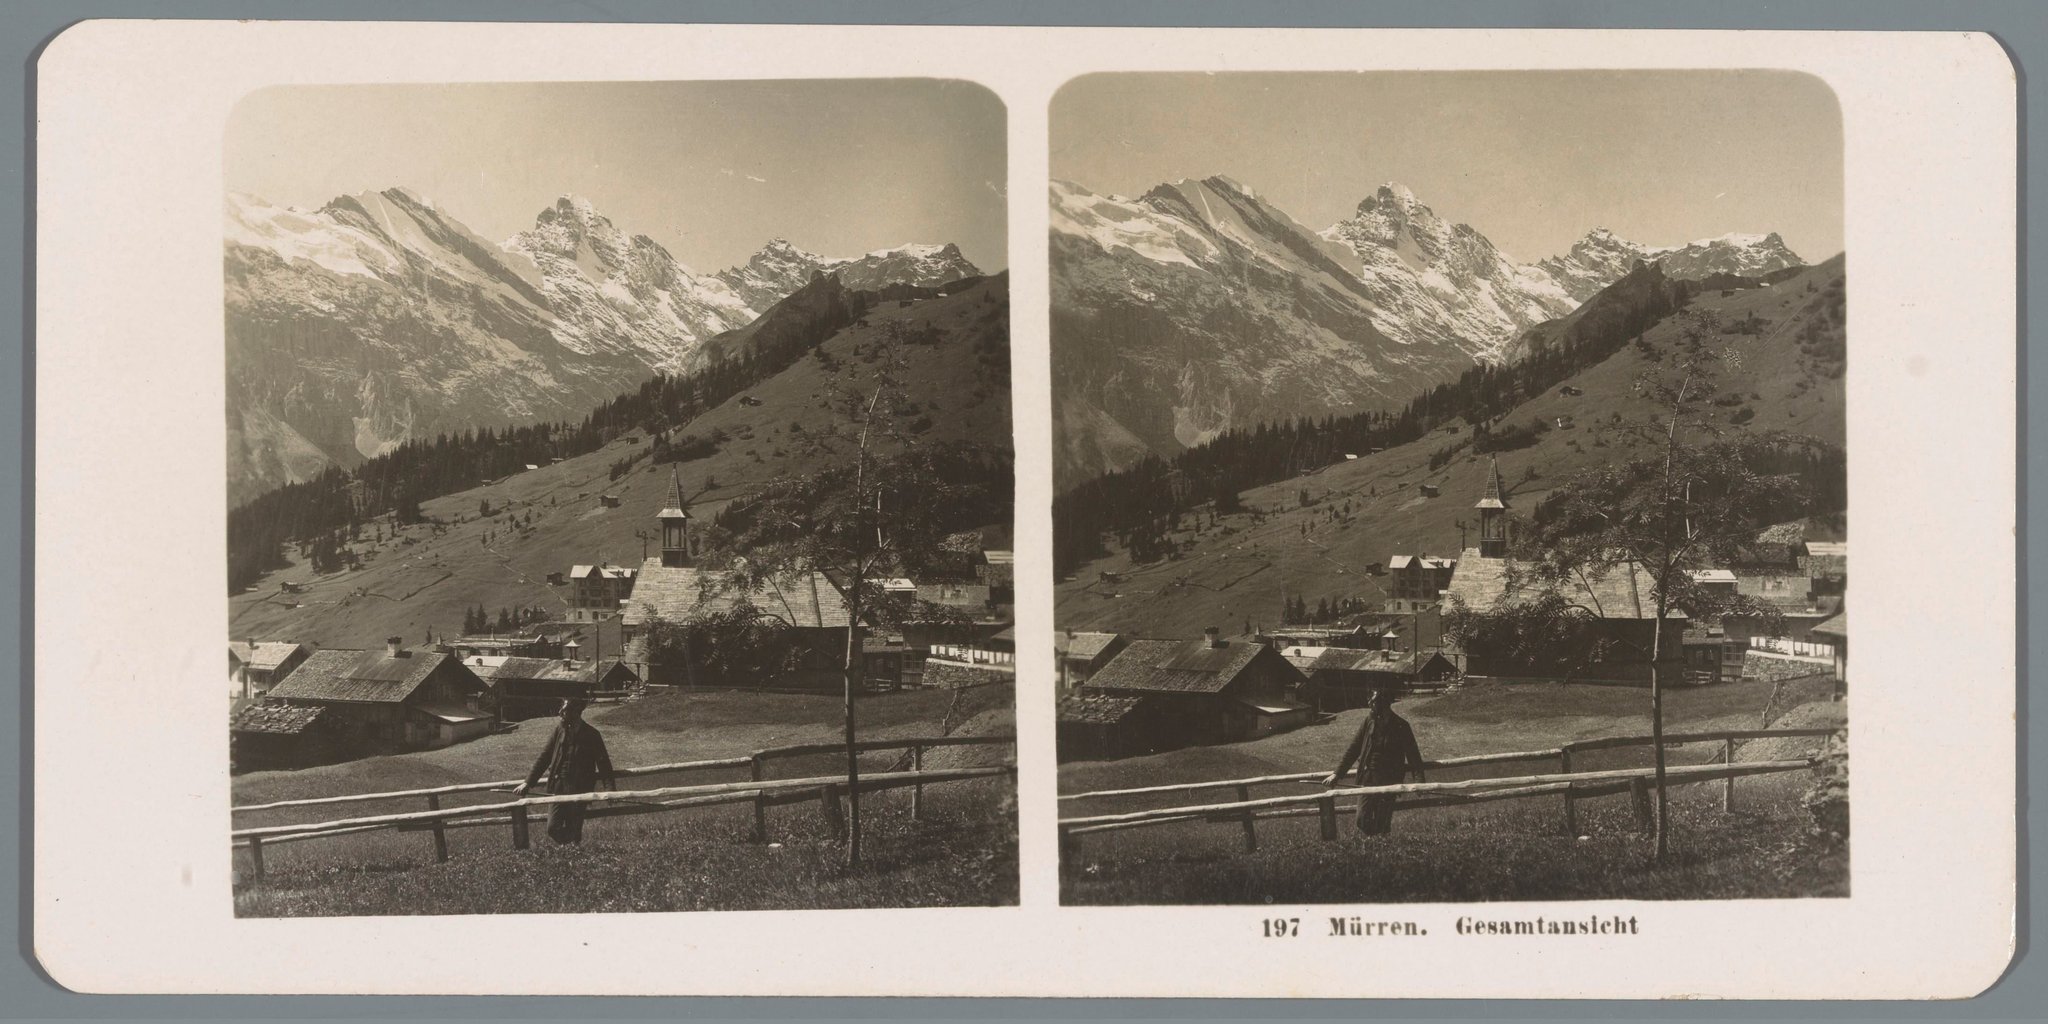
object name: stereograph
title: Mürren. Gesamtansicht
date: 1906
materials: cardboard, photographic support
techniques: gelatin silver print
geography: mürren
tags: city-view in general; 'veduta', mountains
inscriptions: number: ‘197’, inscription: ‘Neue Photographische Gesellschaft A. G., Steglitz-Berlin 1906.’